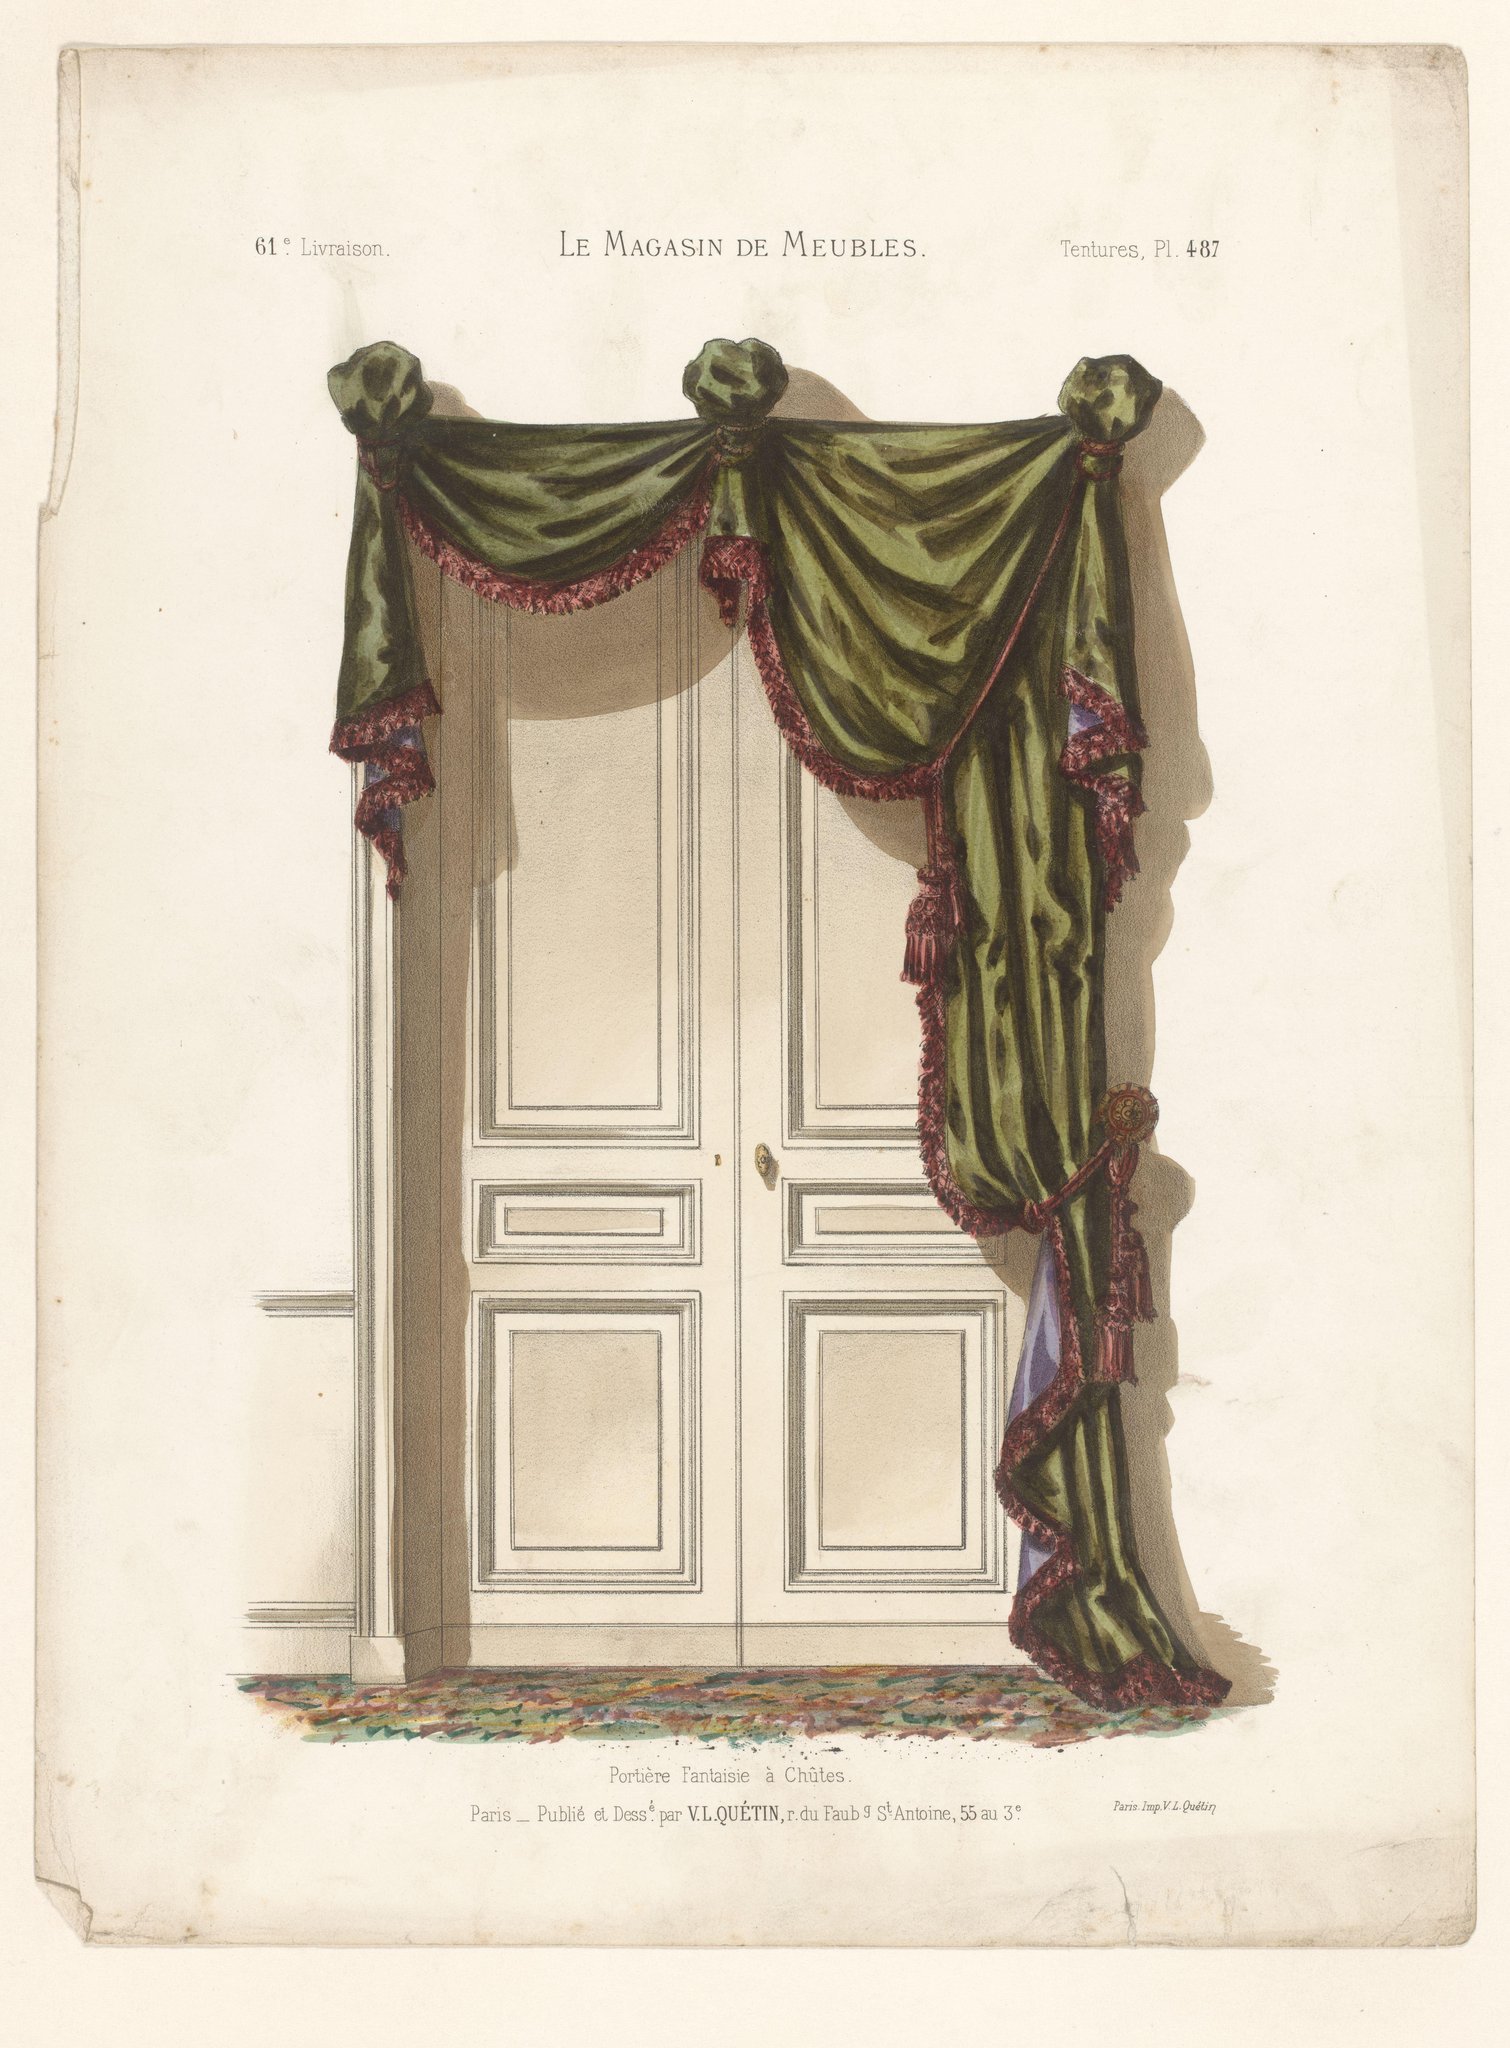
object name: print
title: Venster met gordijnen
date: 1878-1904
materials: paper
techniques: hand coloring, lithograph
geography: paris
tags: window, hangings and drapery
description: Een venster met gedrapeerde gordijnen. Prent uit 60e Livraison.